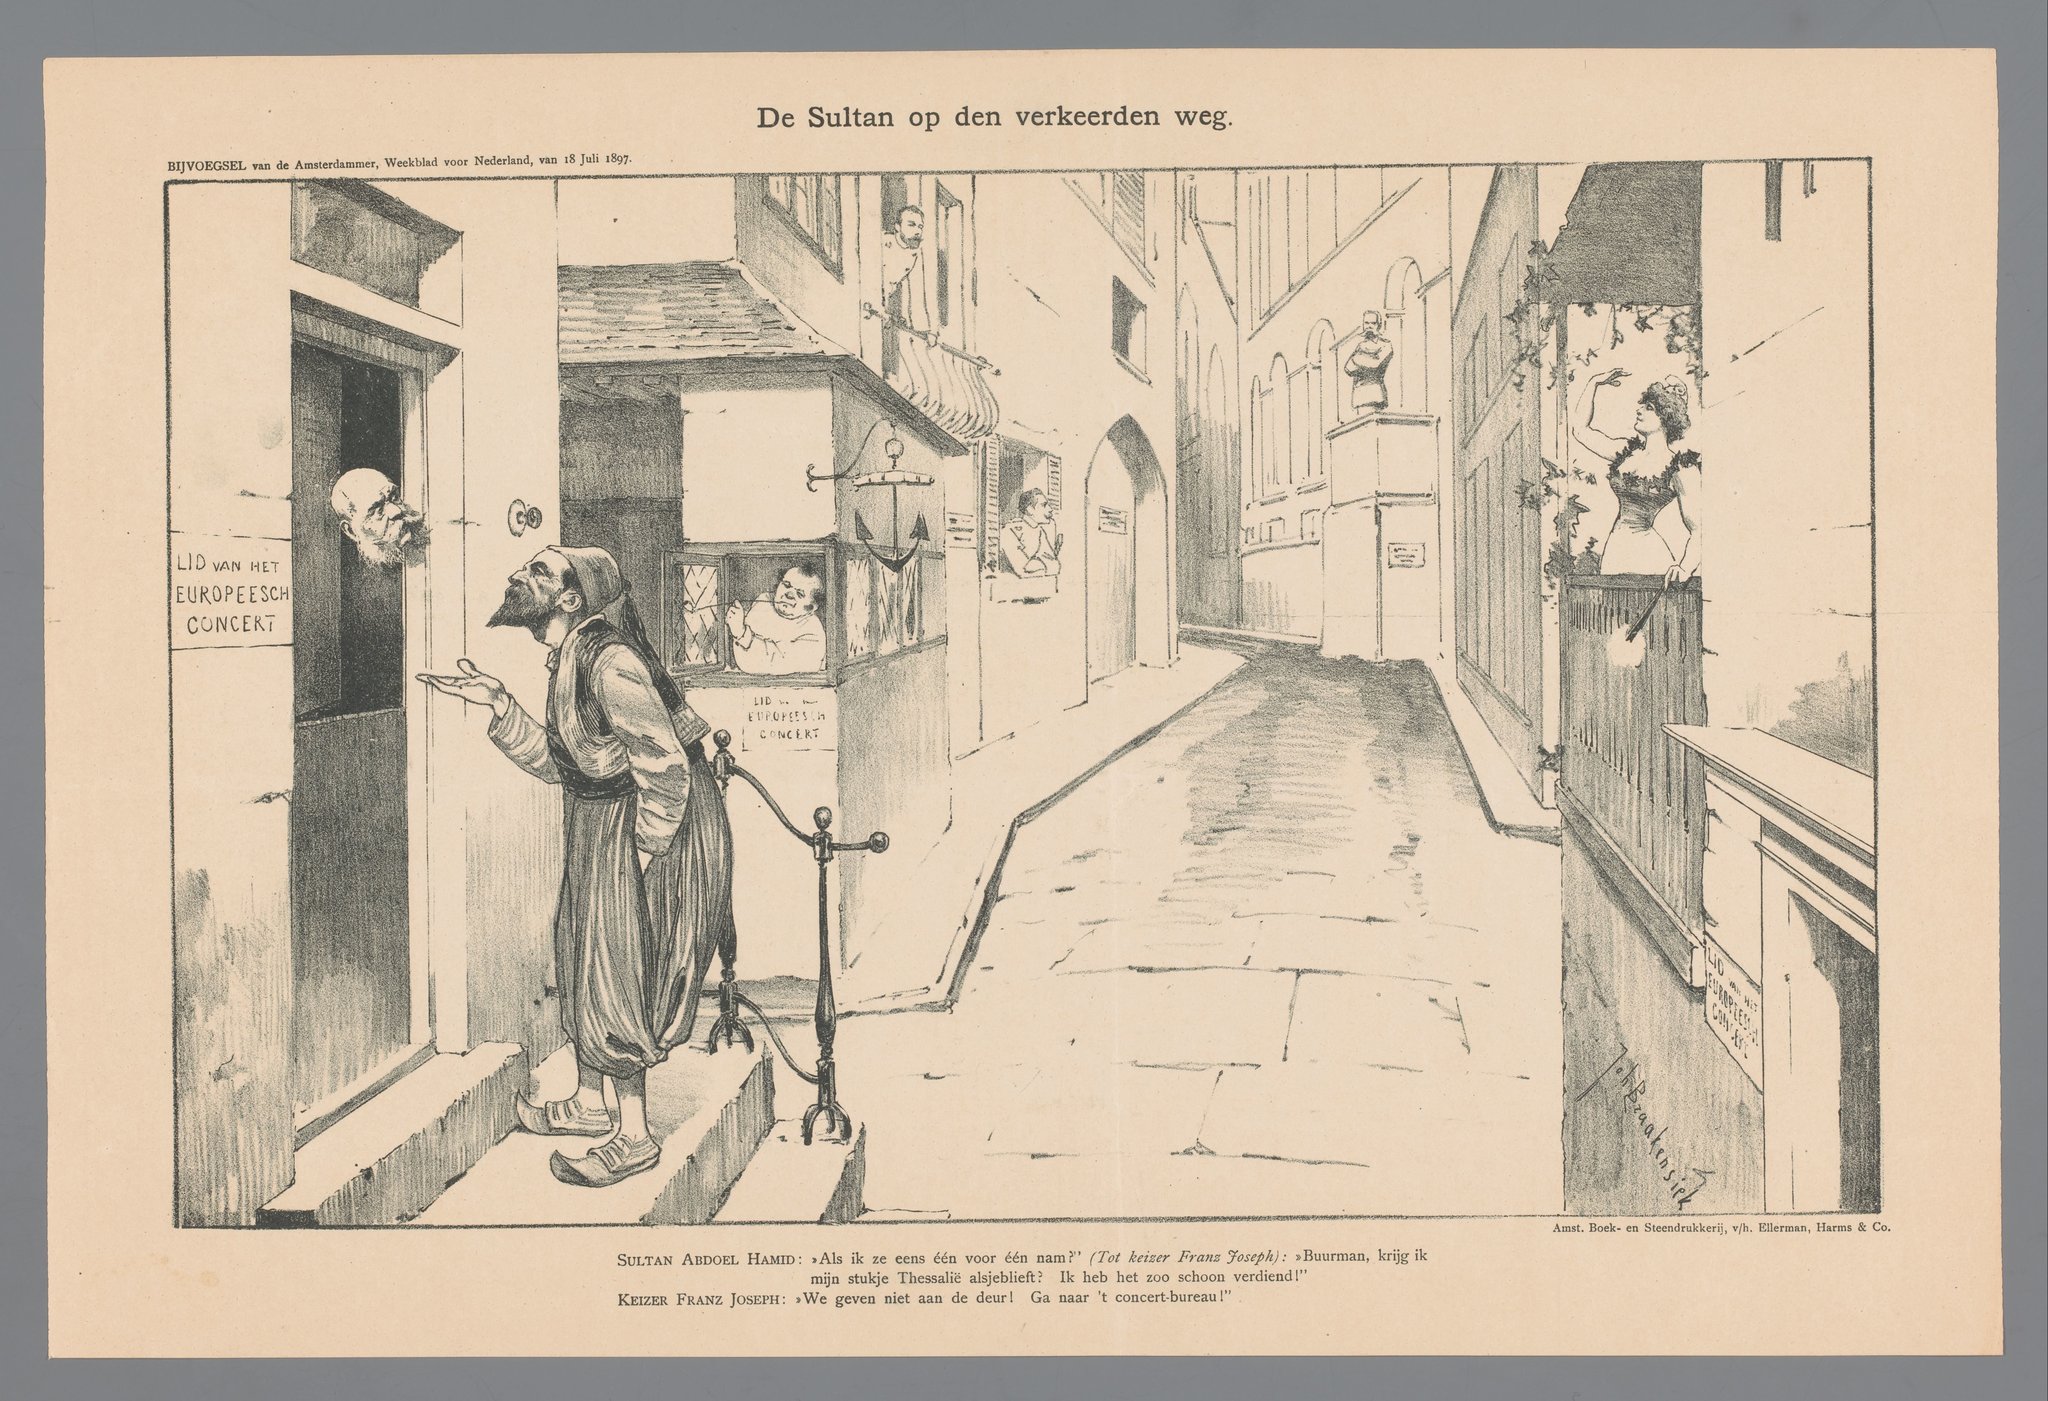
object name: cartoon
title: De sultan op den verkeerden weg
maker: johan braakensiek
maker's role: draughtsman, print maker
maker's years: 1858-1940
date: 1897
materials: paper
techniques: lithograph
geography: amsterdam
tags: vienna, wilhelm ii (keizer van duitsland), historical persons, personifications of countries, nations, states, districts, etc. (+ nation; national), beggar, political caricatures and satires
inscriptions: date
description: Prent uit het bijvoegsel van: De Amsterdammer. Weekblad voor Nederland, 18 juli 1897.